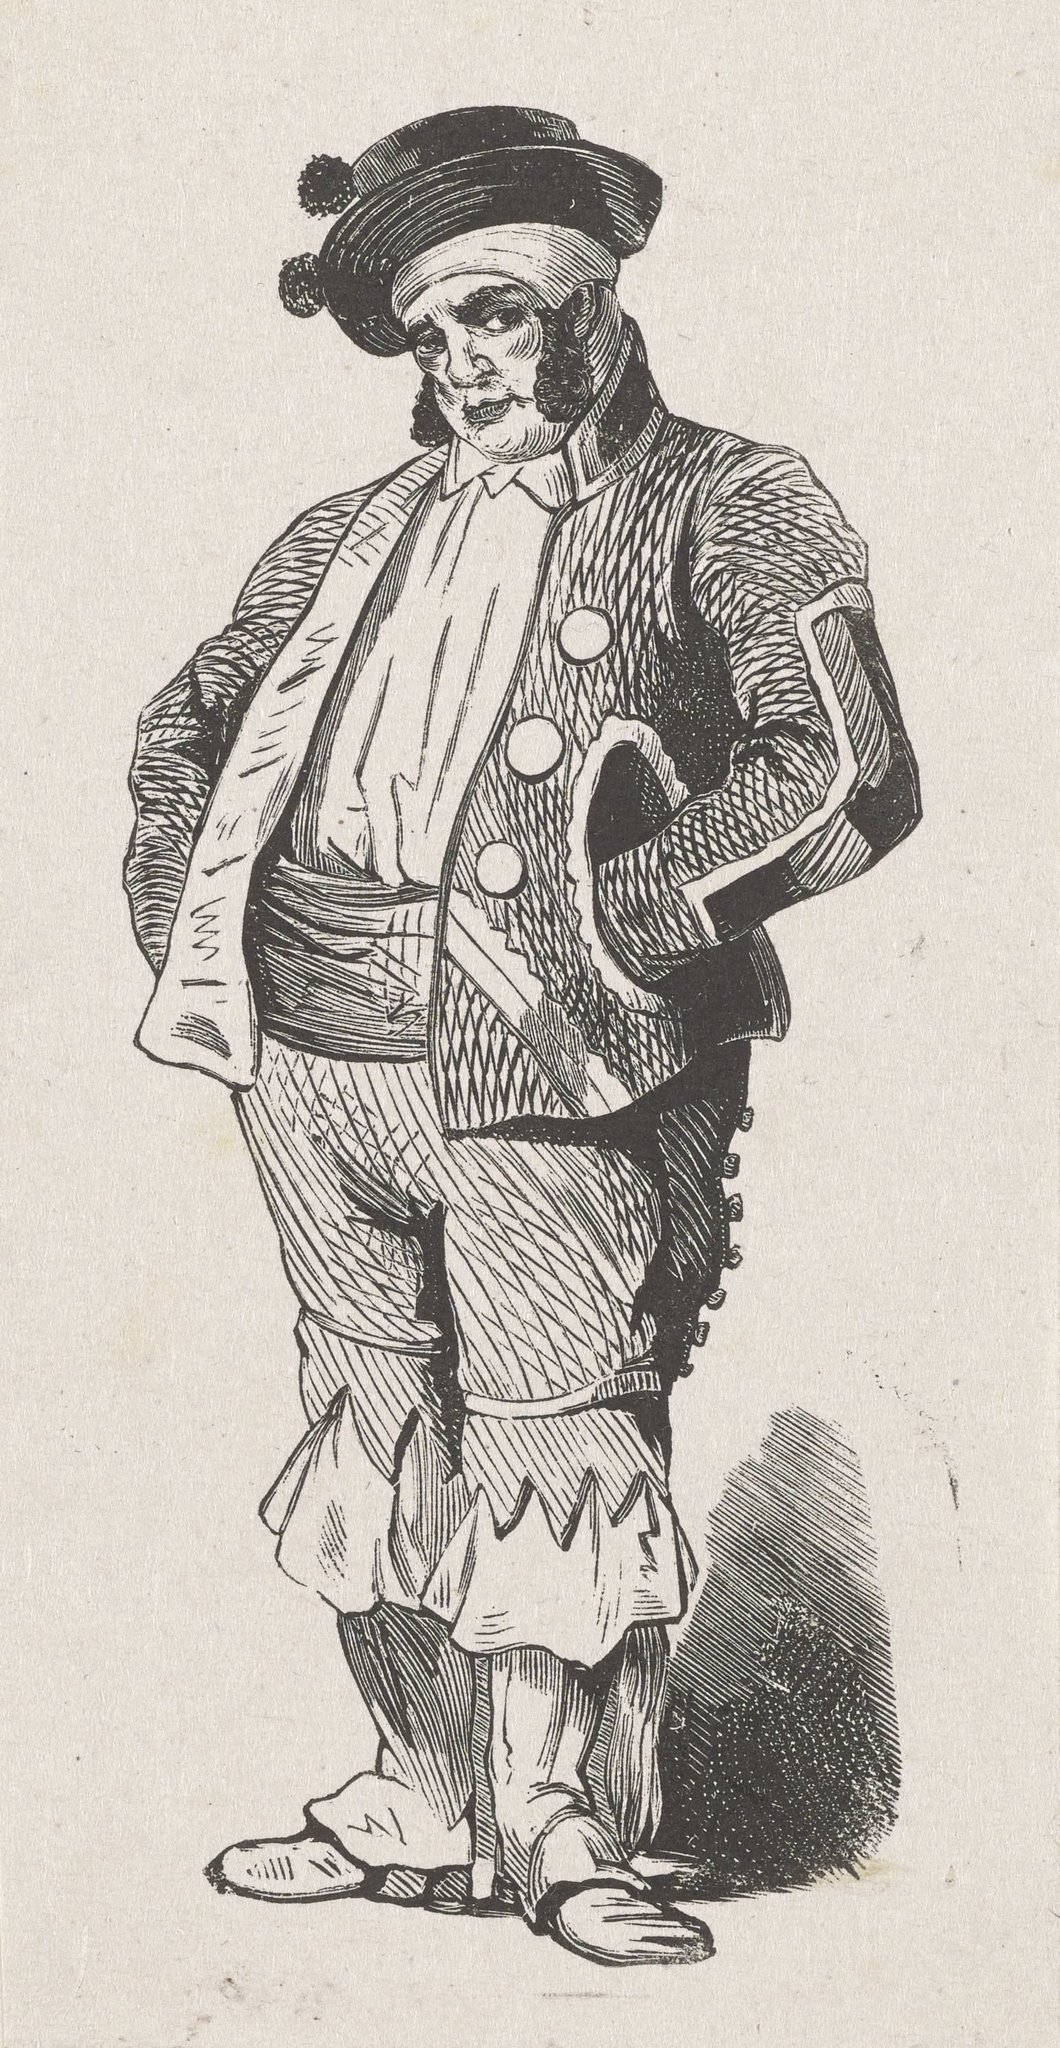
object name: print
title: Staande man met zijn handen in de zakken van zijn jas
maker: isaac weissenbruch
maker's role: print maker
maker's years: 1826-1912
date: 1836-1912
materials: paper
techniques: engraving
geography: netherlands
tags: hand in the pocket - aa - both arms or hands, adult man (+ standing)